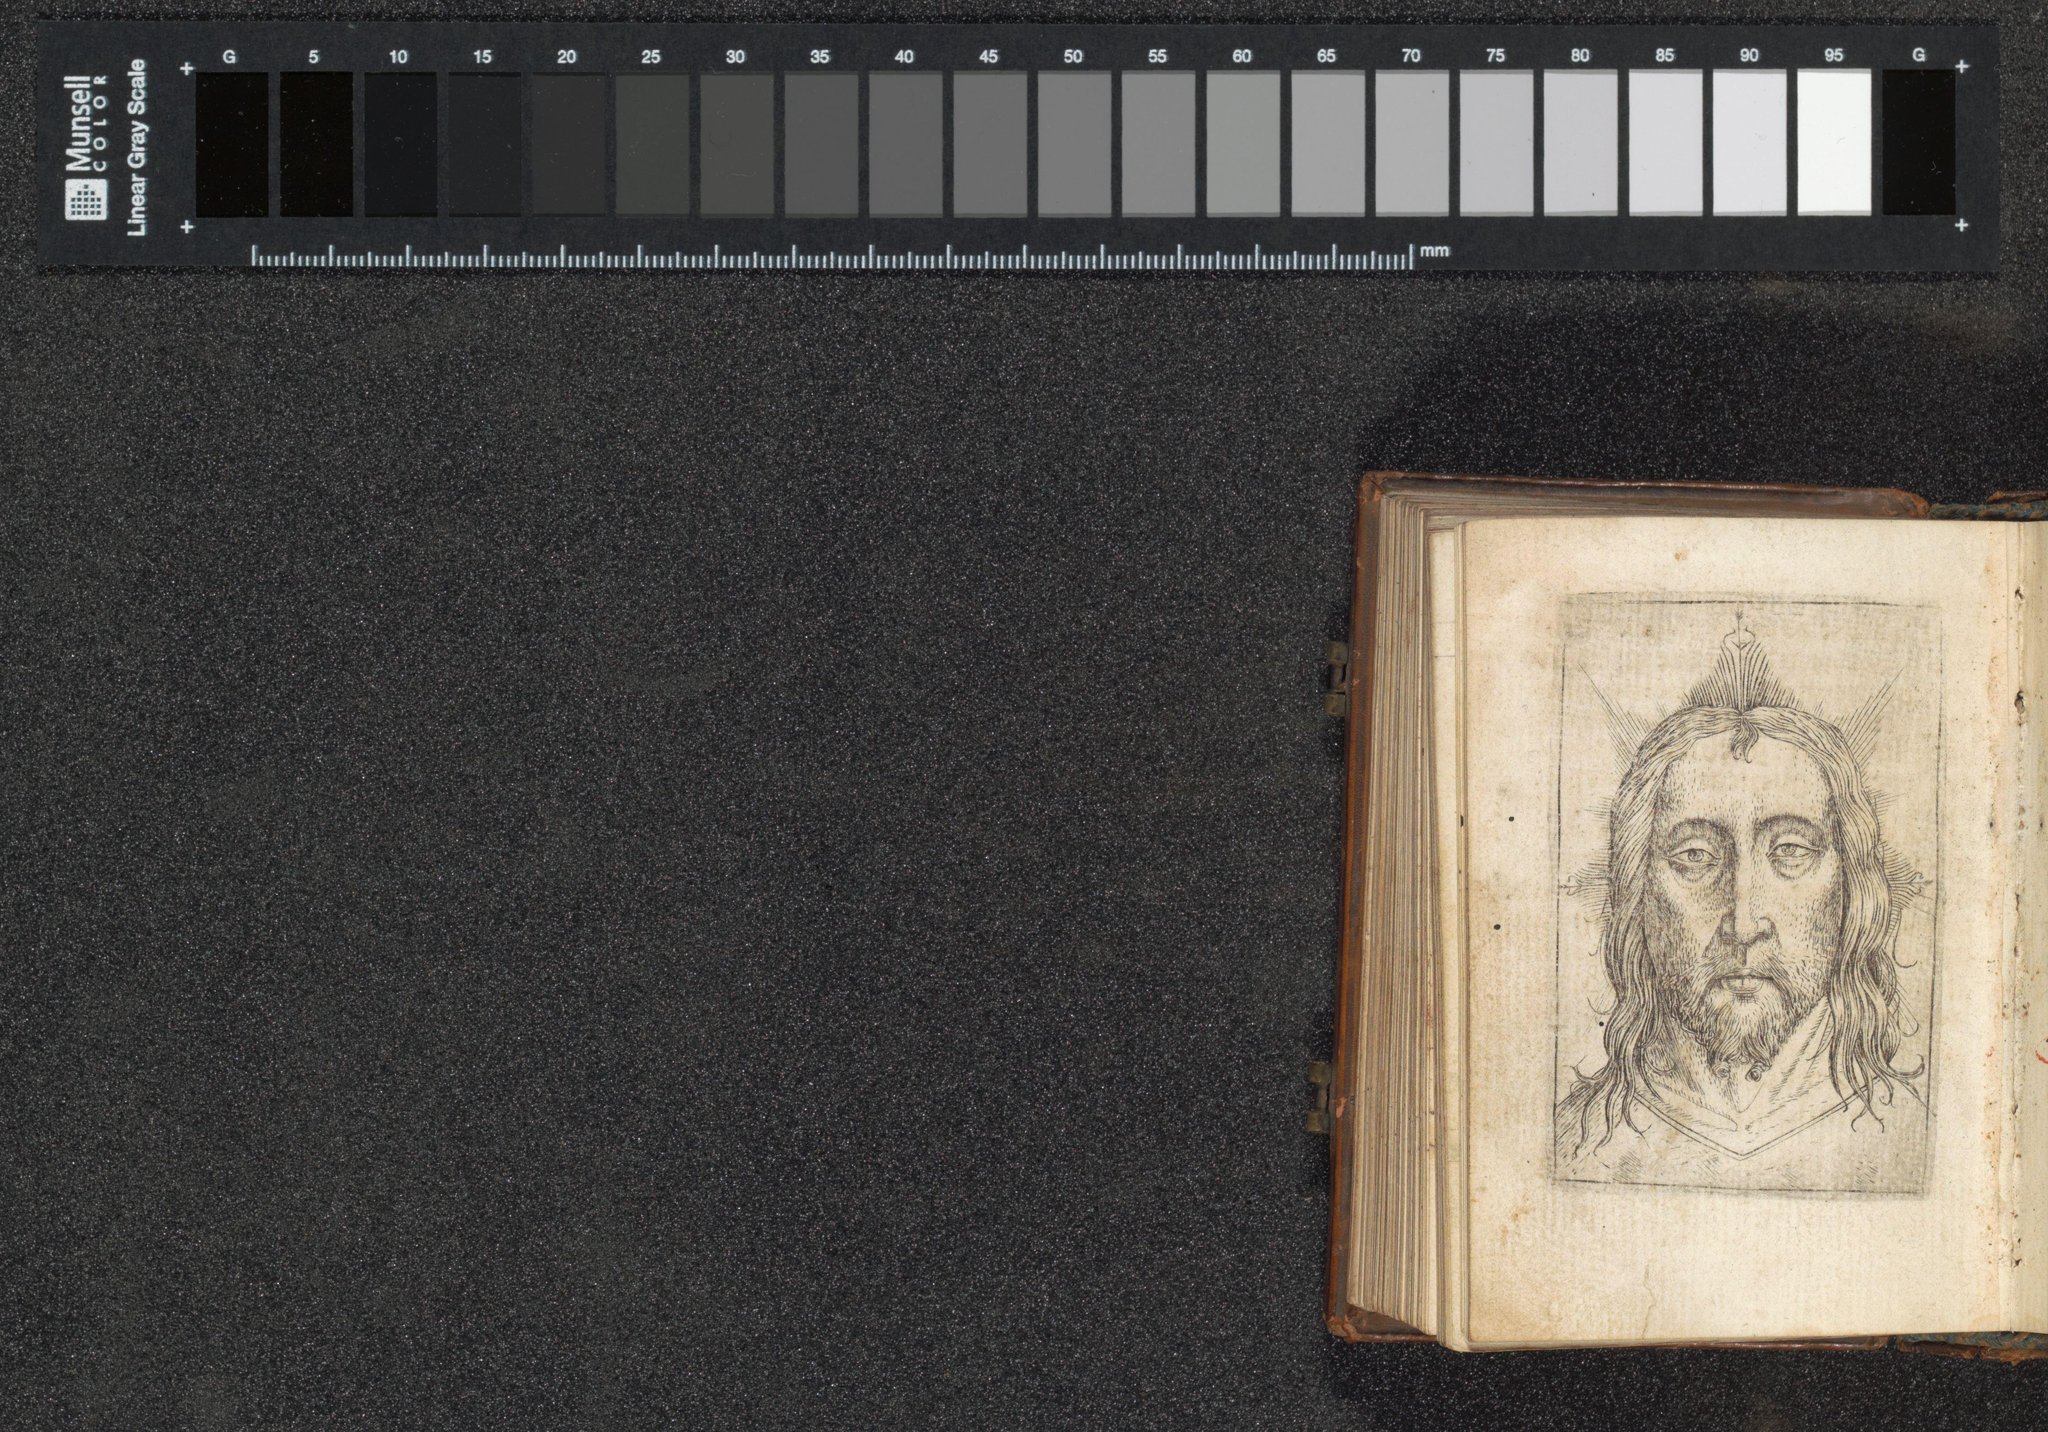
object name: print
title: Face of Christ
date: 1480-1510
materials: paper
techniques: engraving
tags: 'portraits' of christ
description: The manuscript was probably compiled for novices of a Dutch Augustinian monastery. A print of the face of Christ was pasted on a page that was intentionally left blank, as an incentive to prayer and meditation. The Christ type in this hitherto unknown engraving closely resembles painted versions by the Flemish masters Rogier van der Weyden and Dirck Bouts.